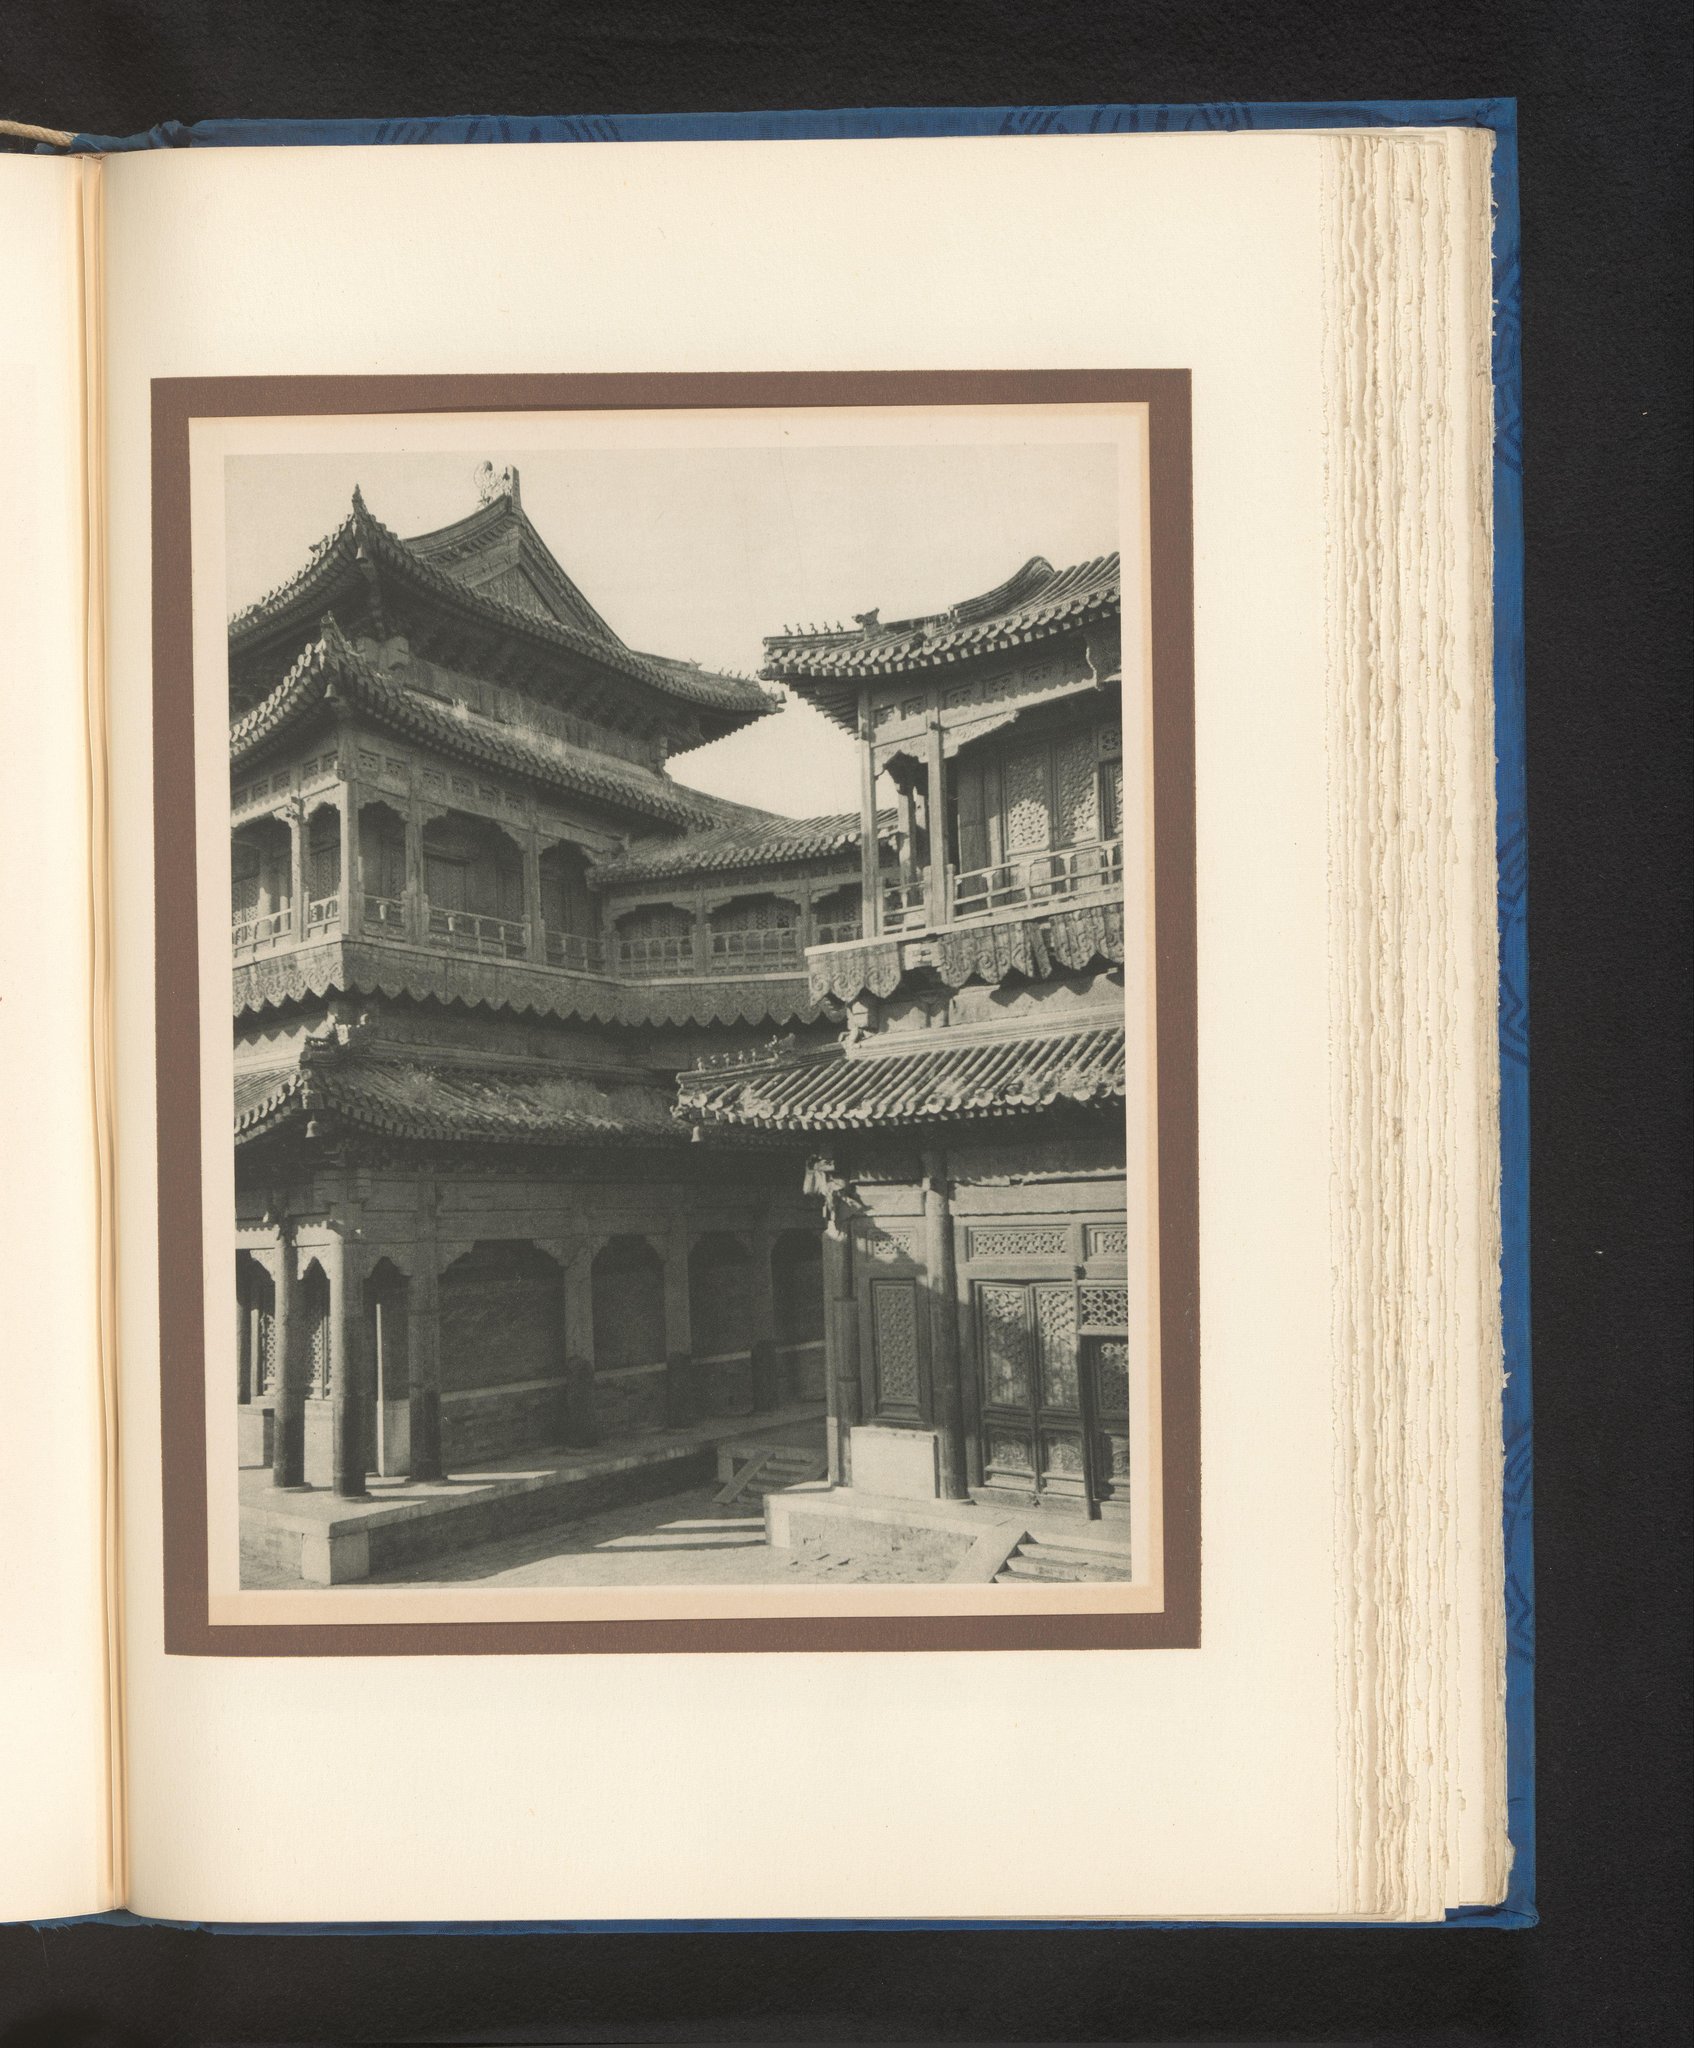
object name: photomechanical print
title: Yonghetempel te Peking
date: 1915-1920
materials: paper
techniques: rotogravure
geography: beijing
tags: temple, shrine ~ non-christian religions